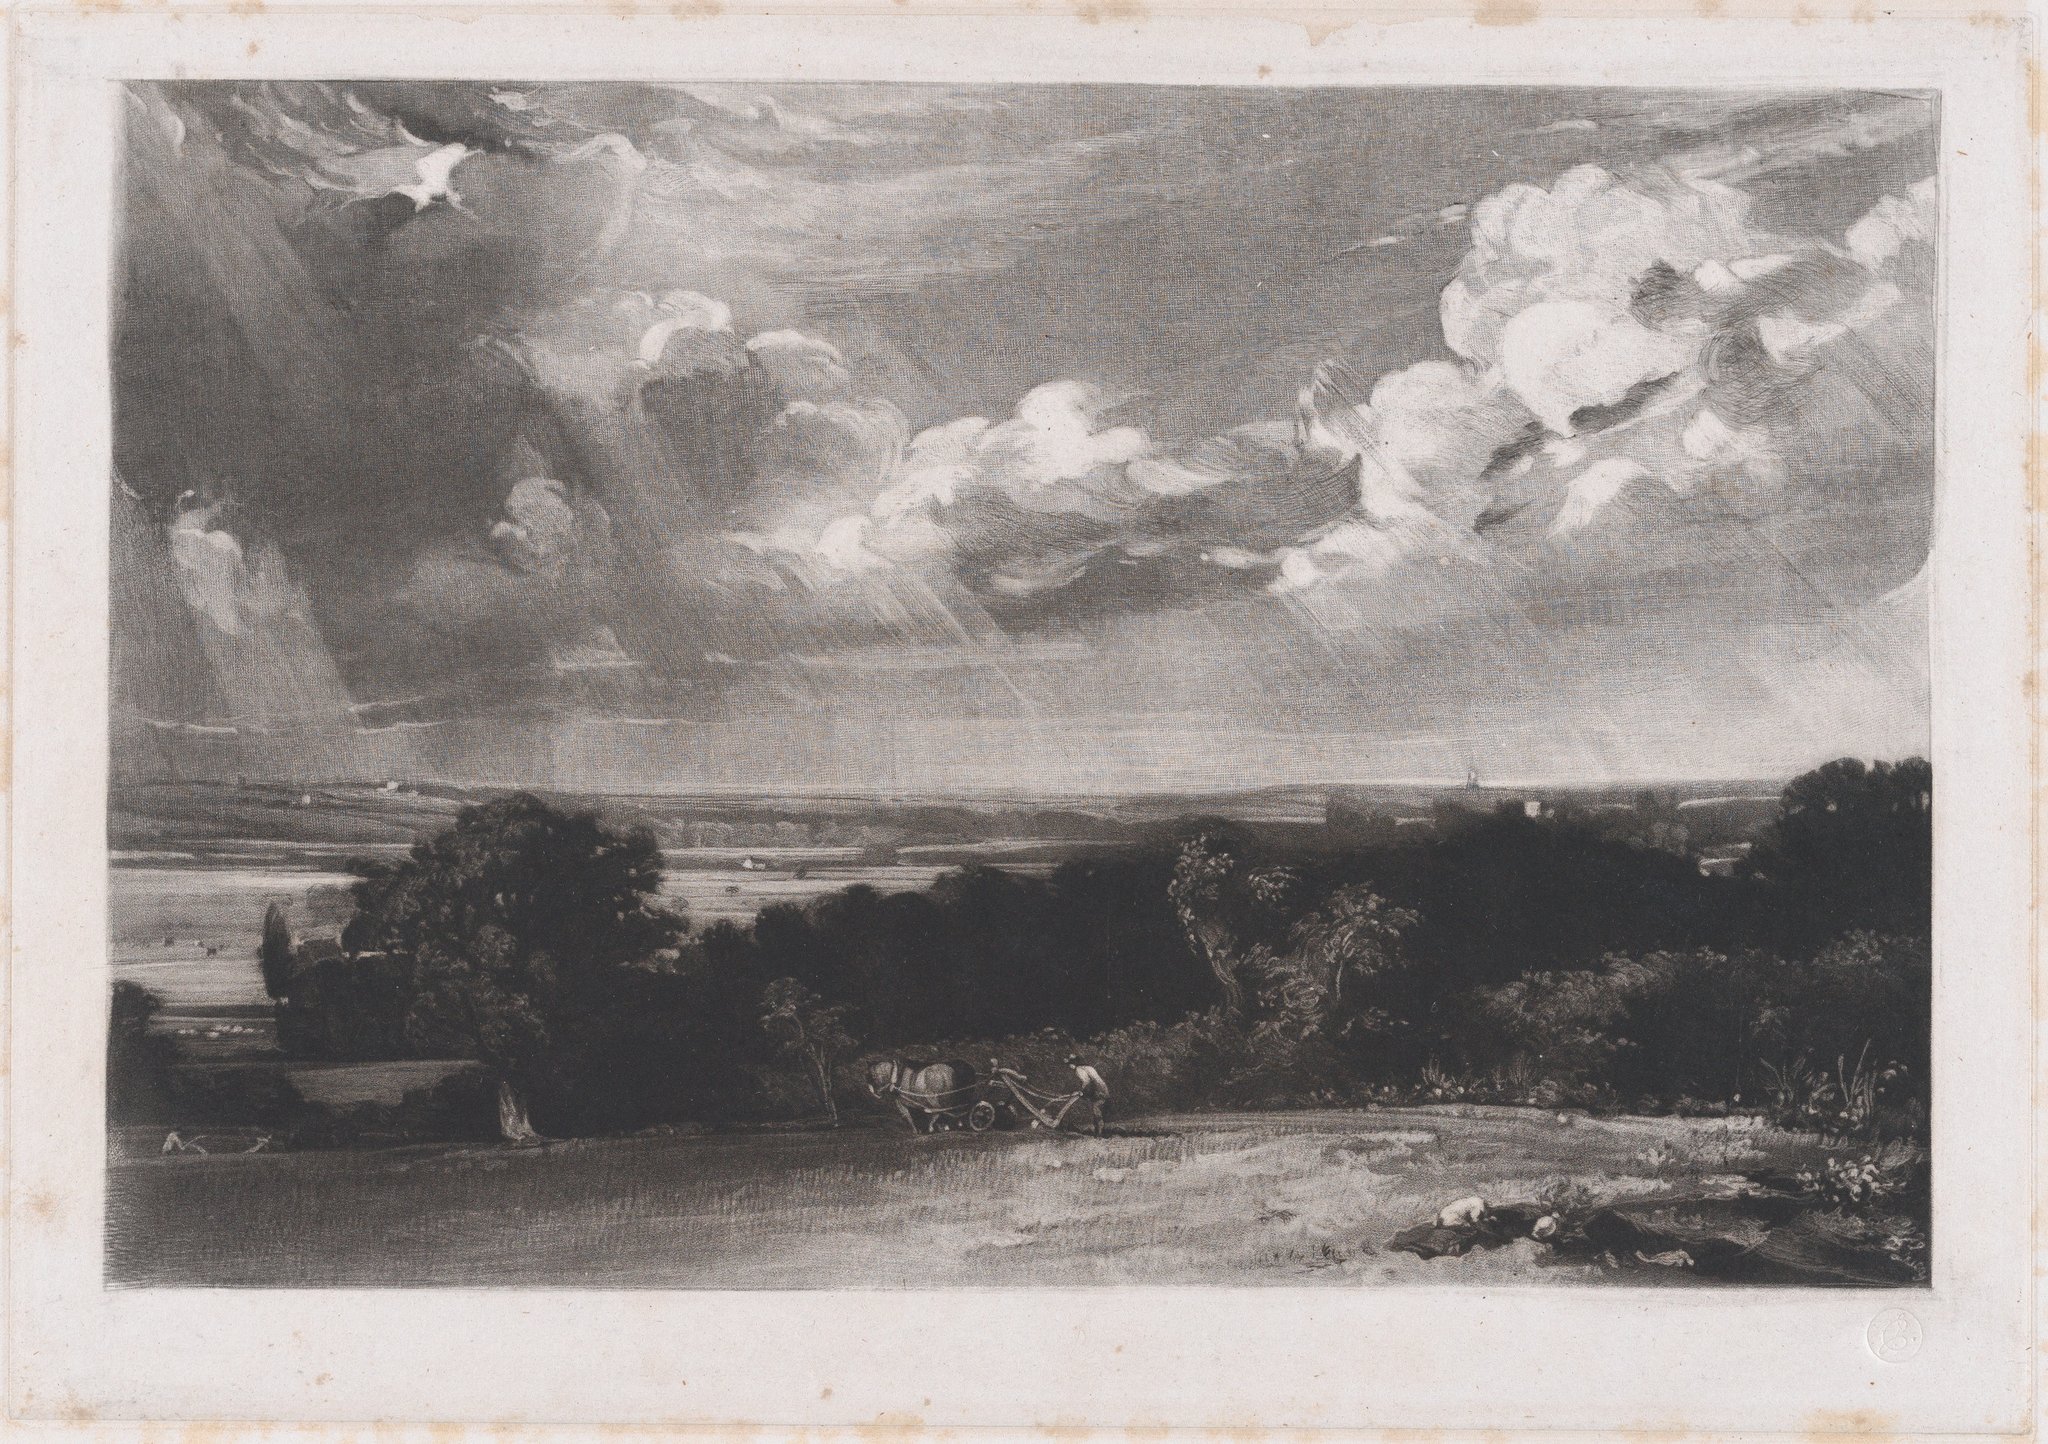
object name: print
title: A Summerland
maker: david lucas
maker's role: artist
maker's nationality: british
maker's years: 1802-1881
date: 1829-1831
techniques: mezzotint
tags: landscapes